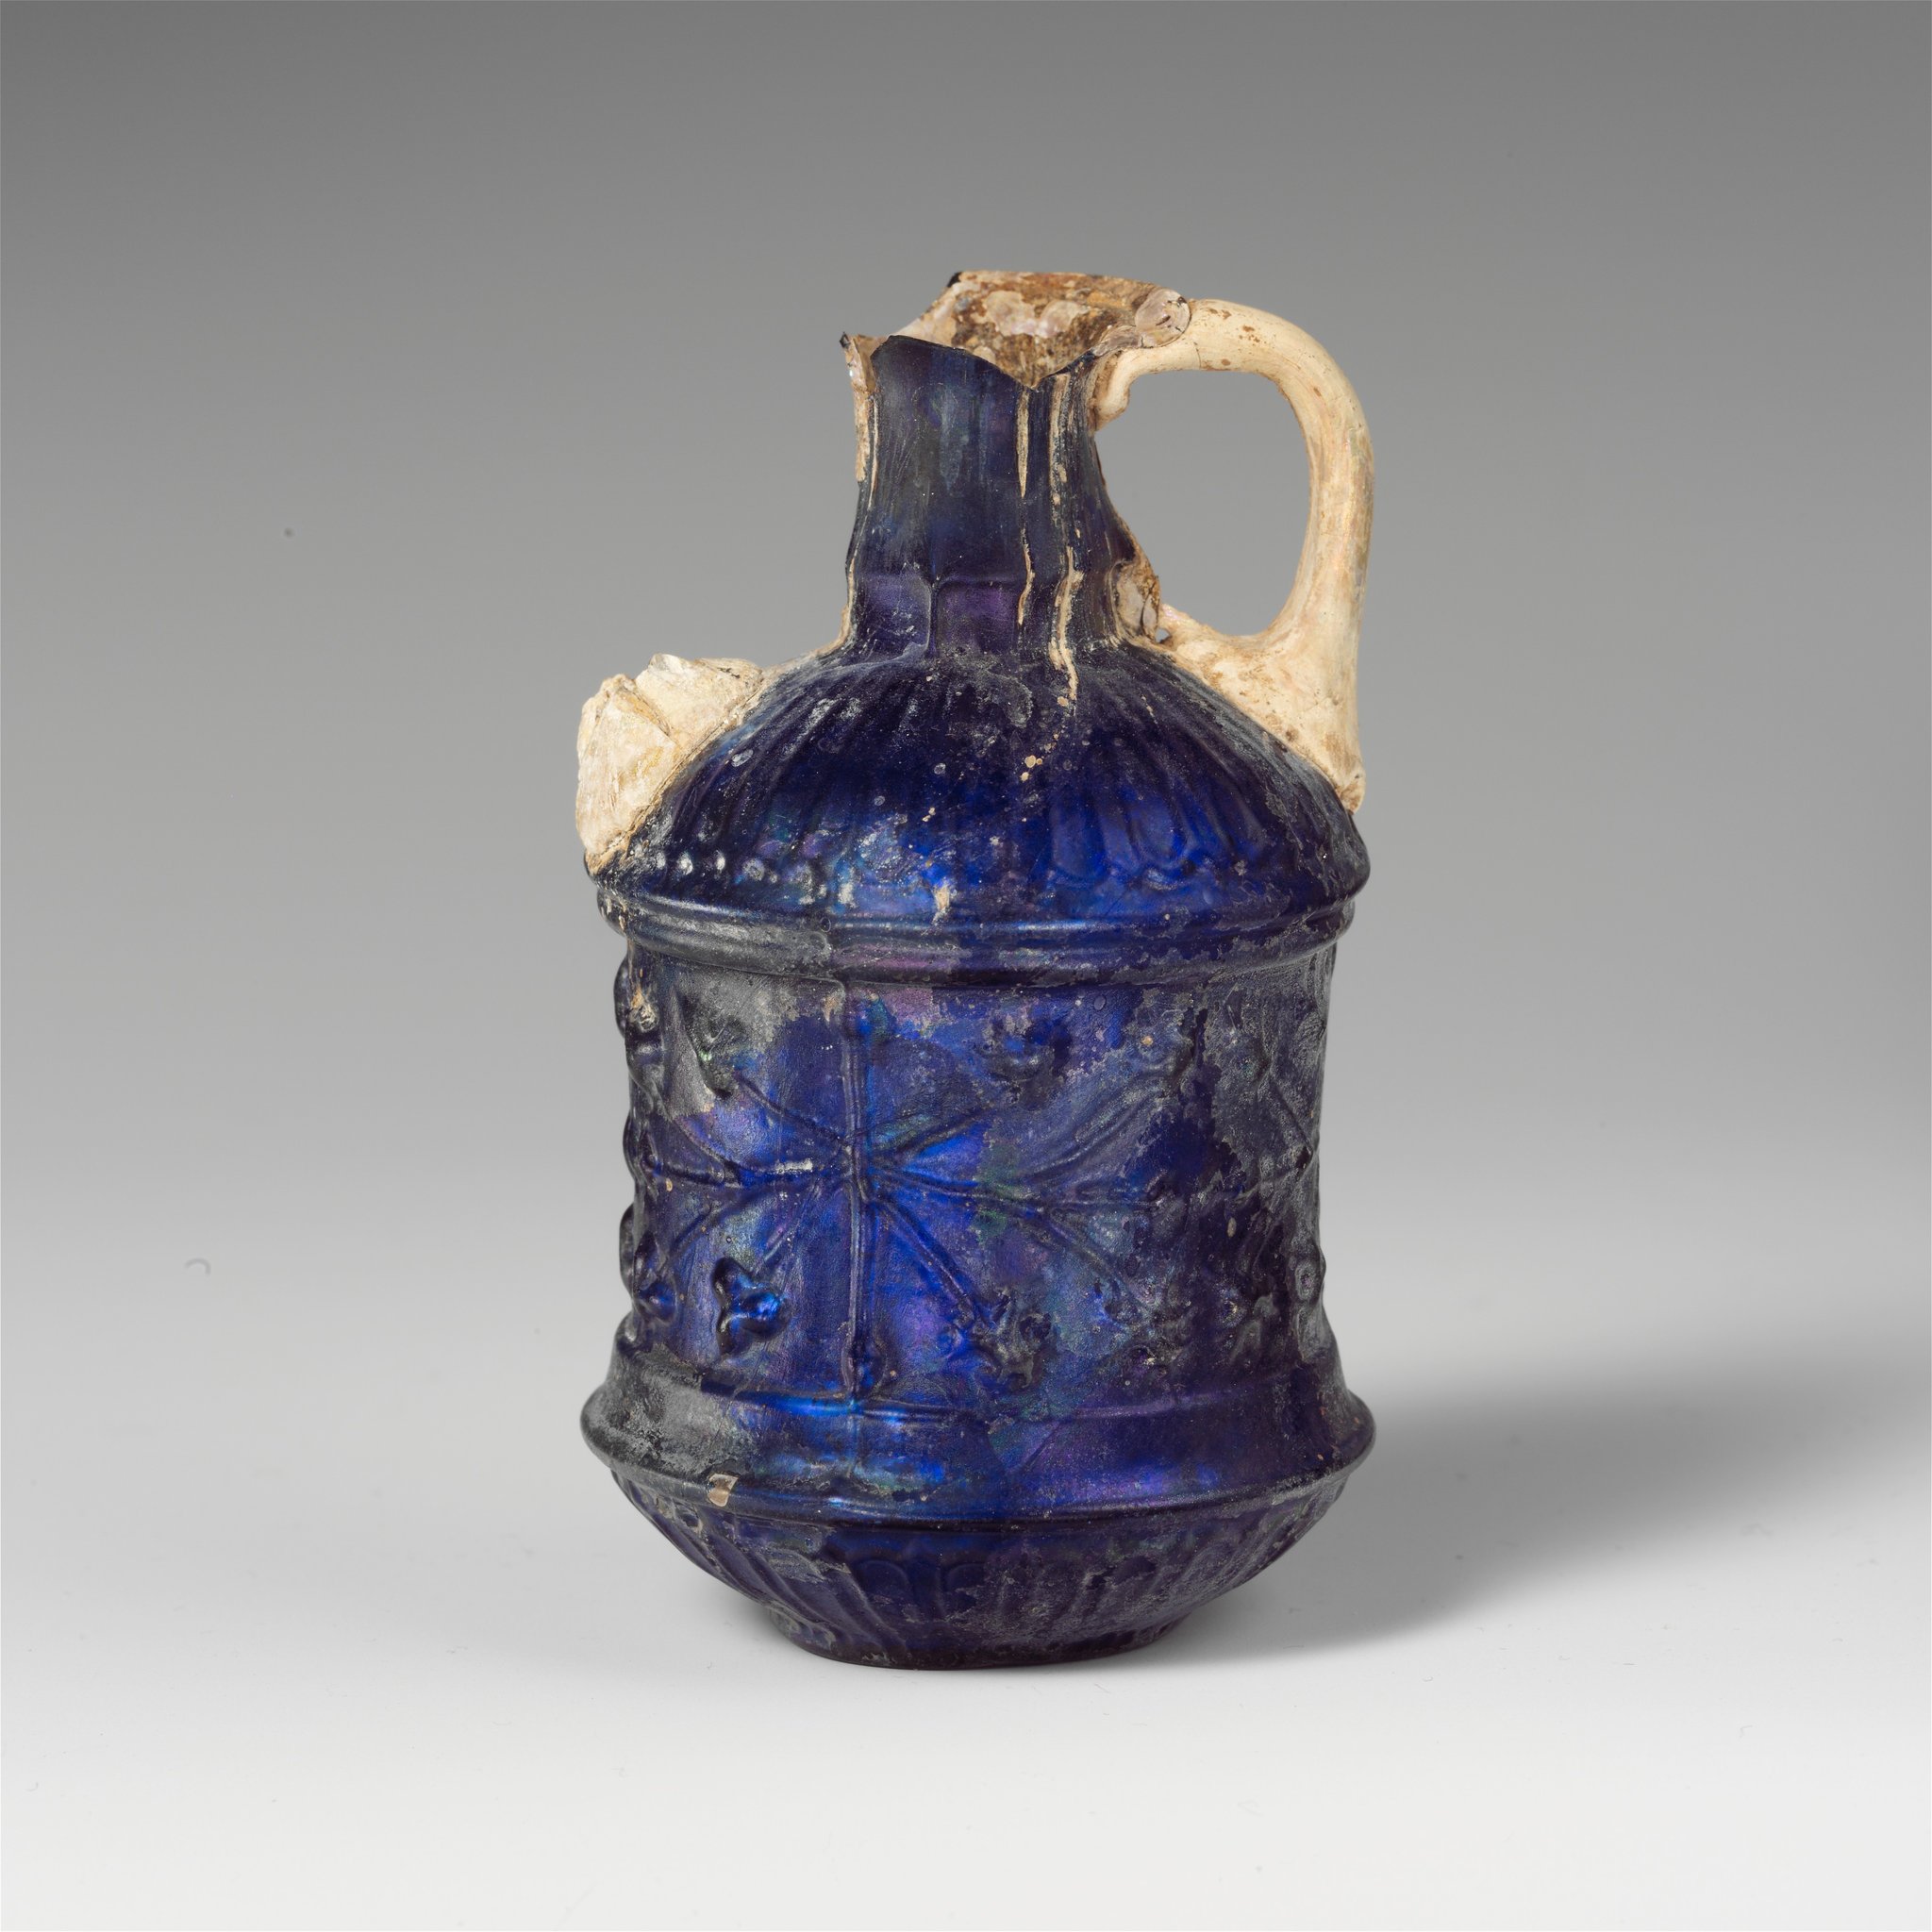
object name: bottle, two handled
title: Glass two-handled bottle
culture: roman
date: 1-50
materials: glass